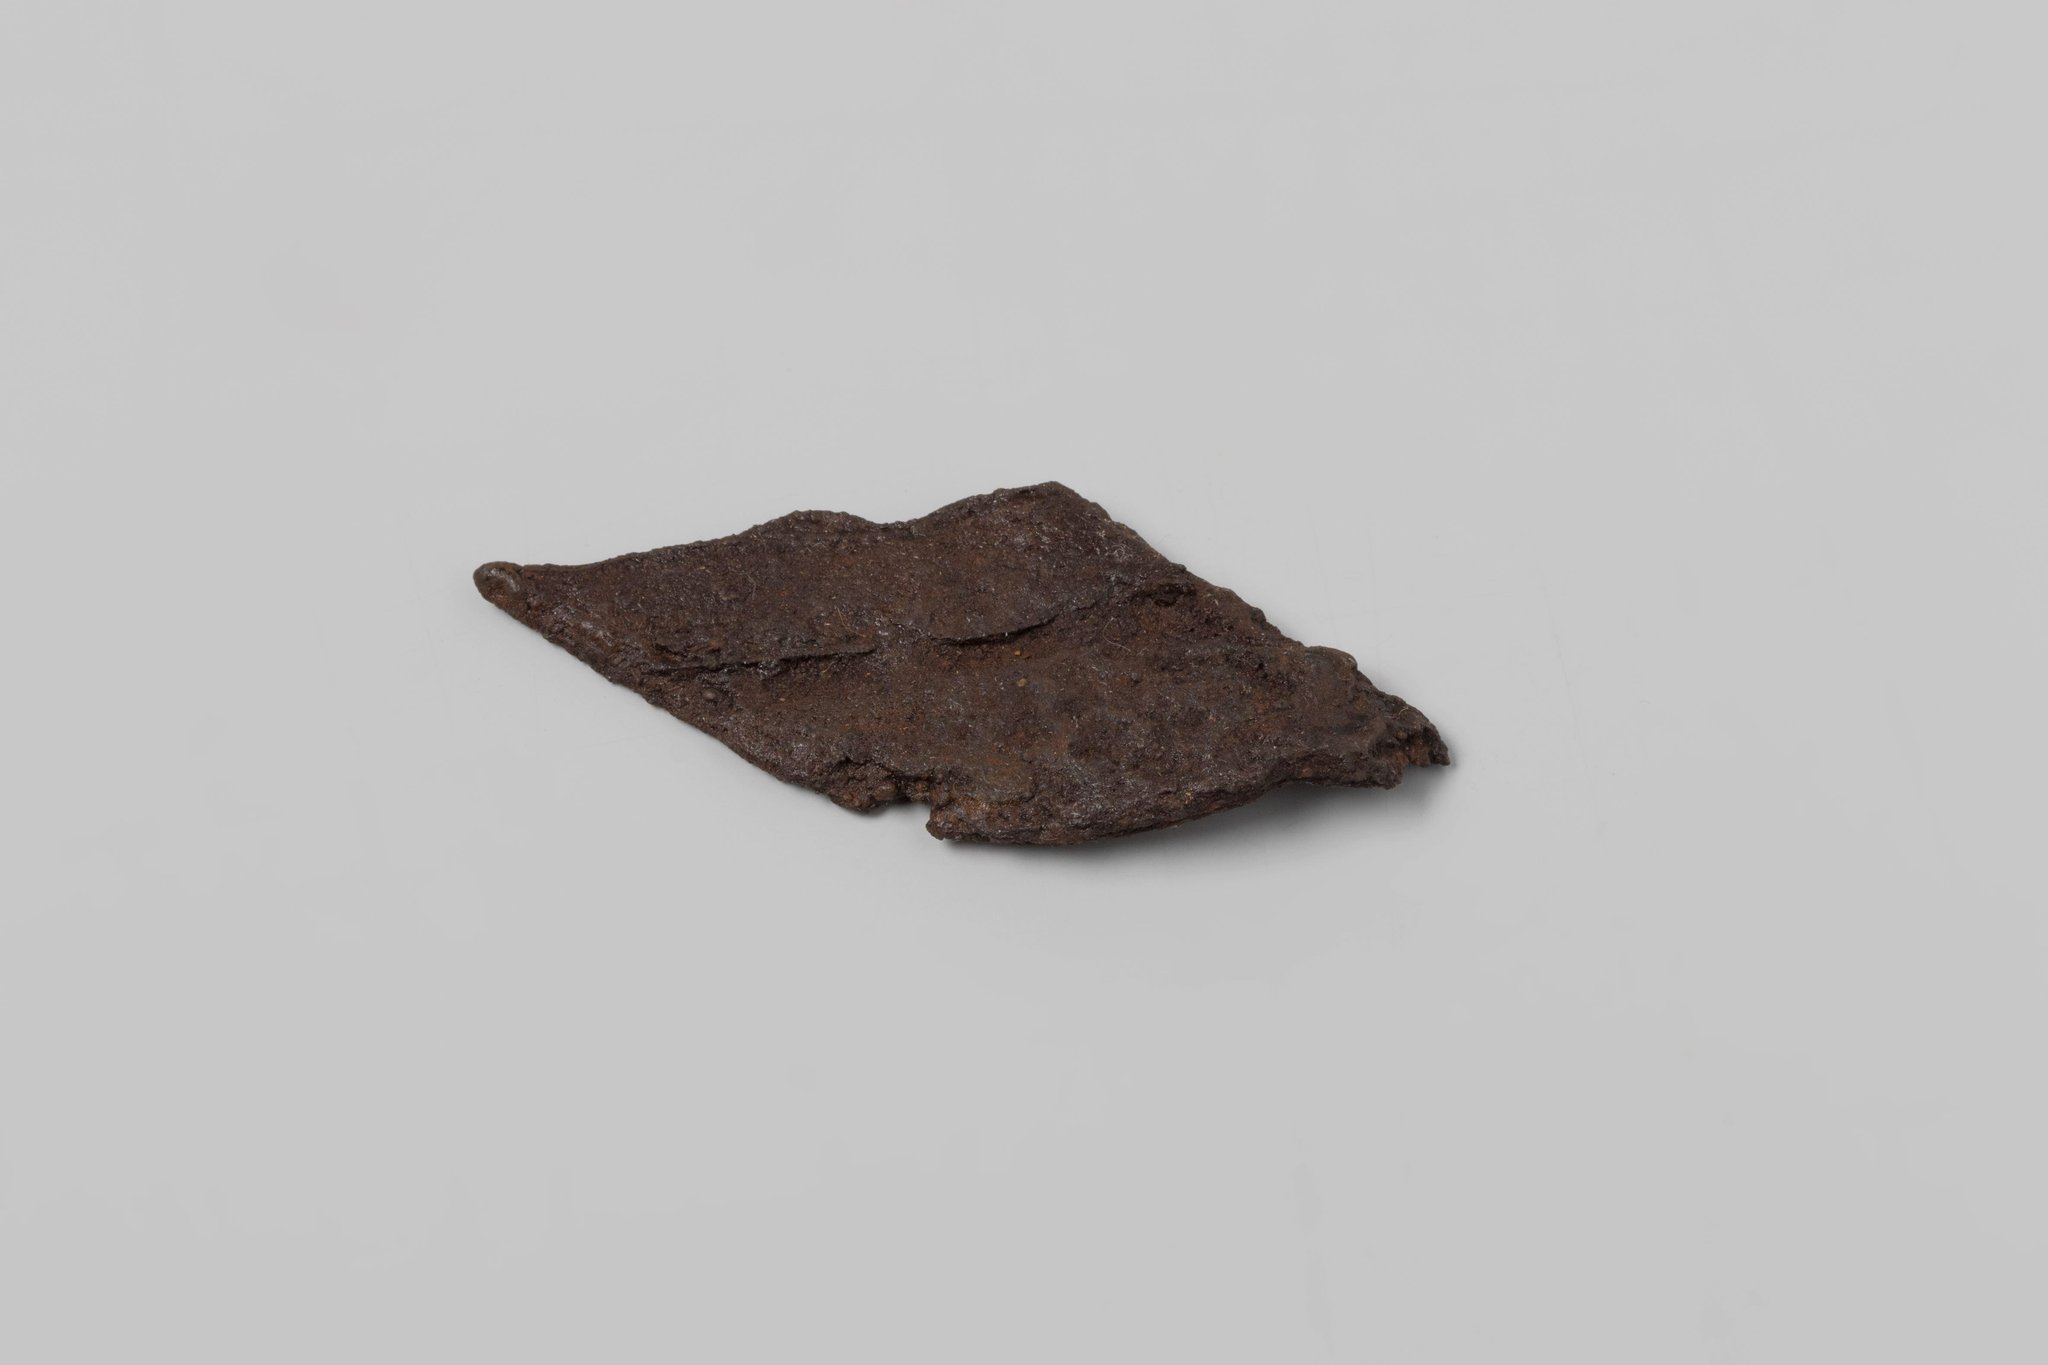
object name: fragment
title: Fragment ijzer uit het wrak van de Oost-Indiëvaarder Hollandia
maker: Anonymous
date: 1700-1743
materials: iron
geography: netherlands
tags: verenigde oostindische compagnie, hollandia (schip), annet